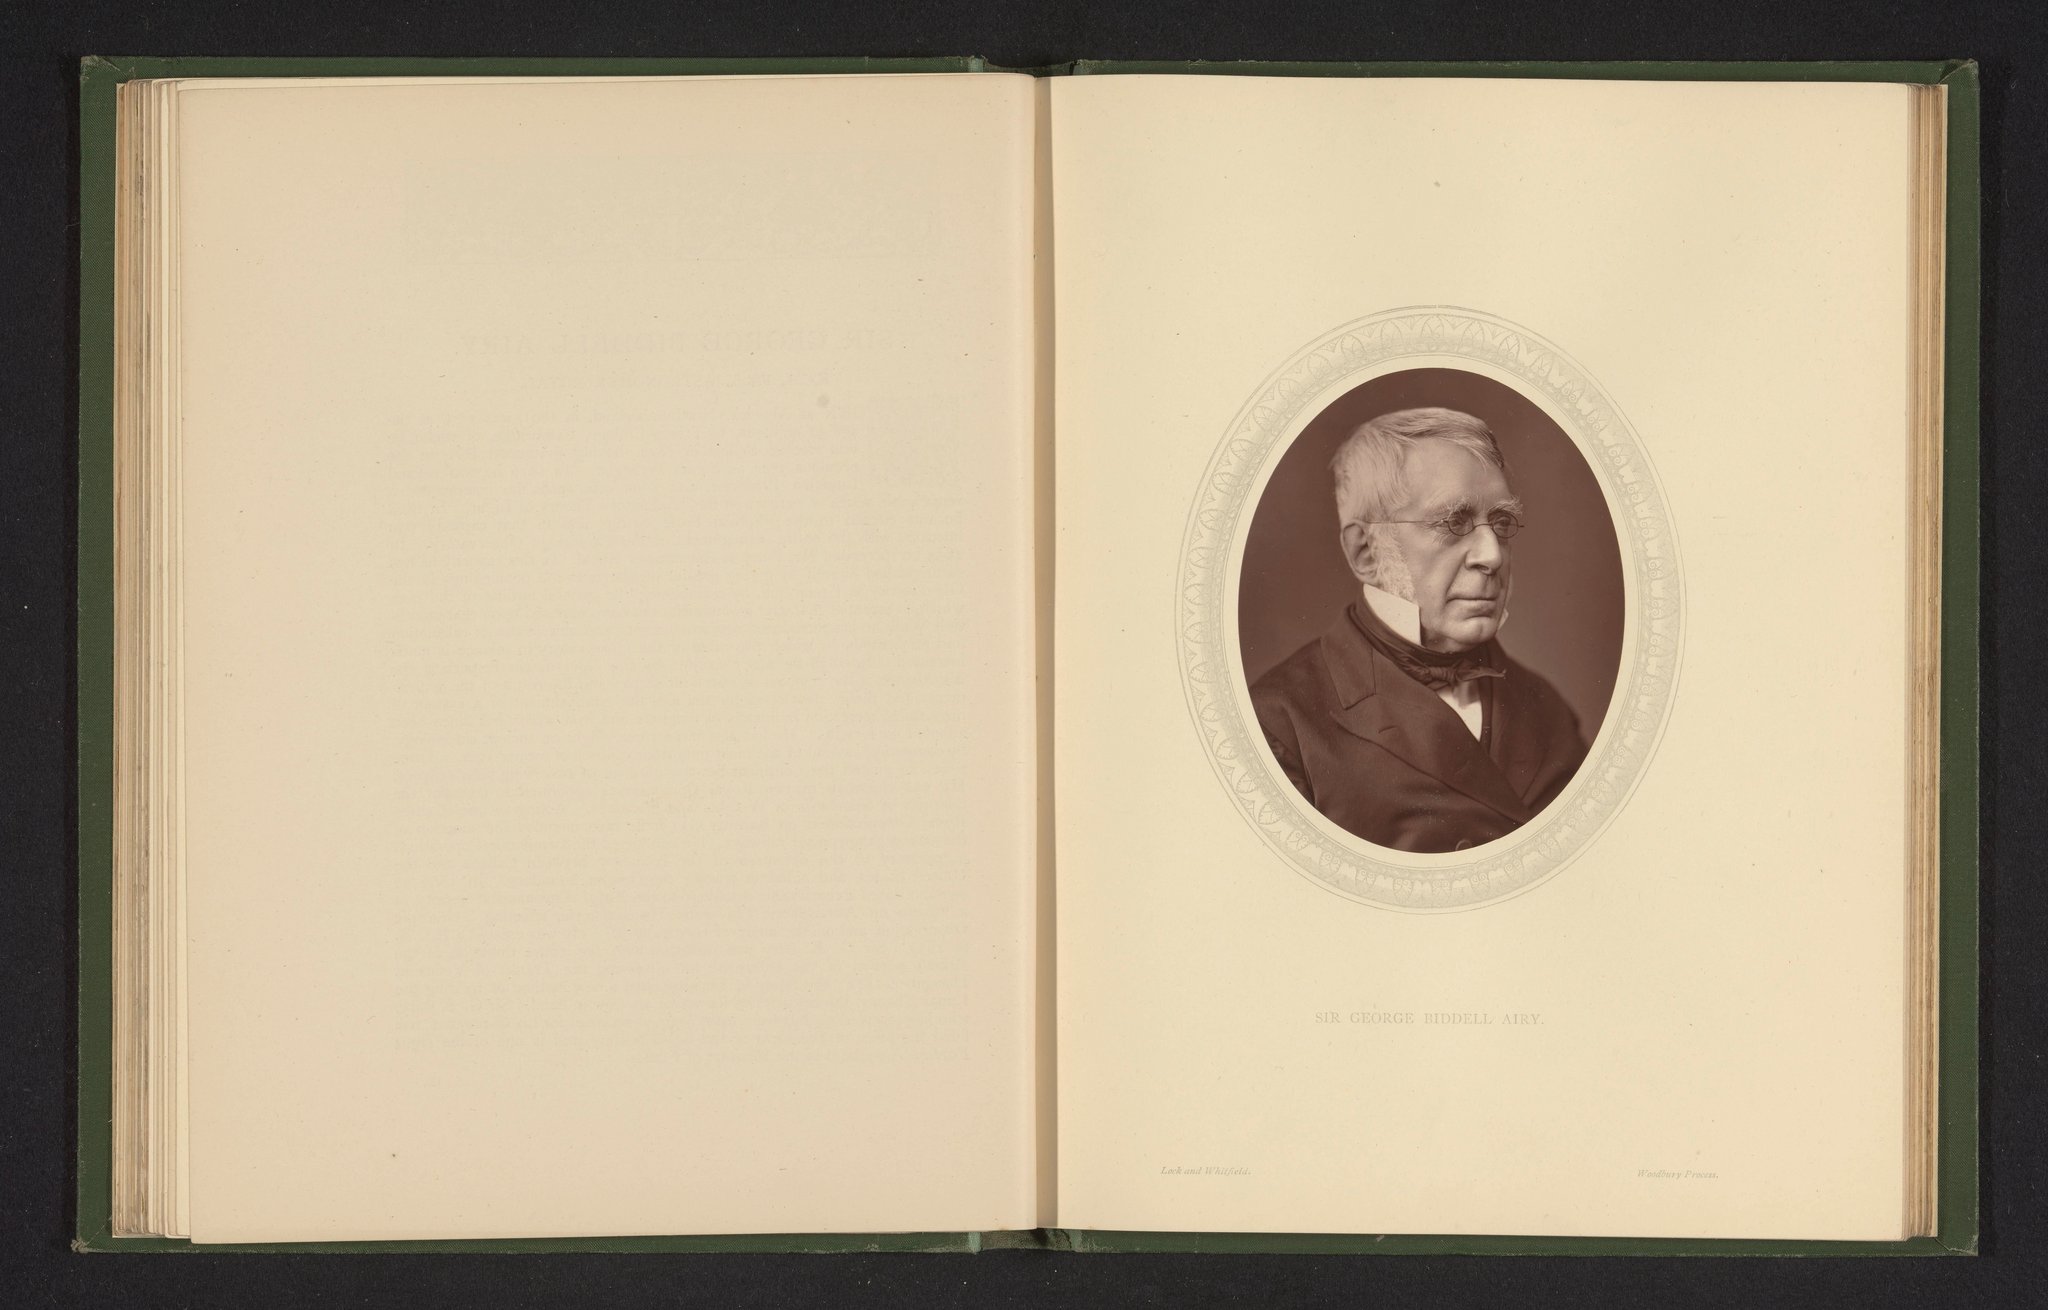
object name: page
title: Sir George Biddell Airy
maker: Anonymous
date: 1872-1877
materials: paper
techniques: woodburytype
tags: historical persons (portraits and scenes from the life) (+ (full) bust portrait), politician, e.g. party leader